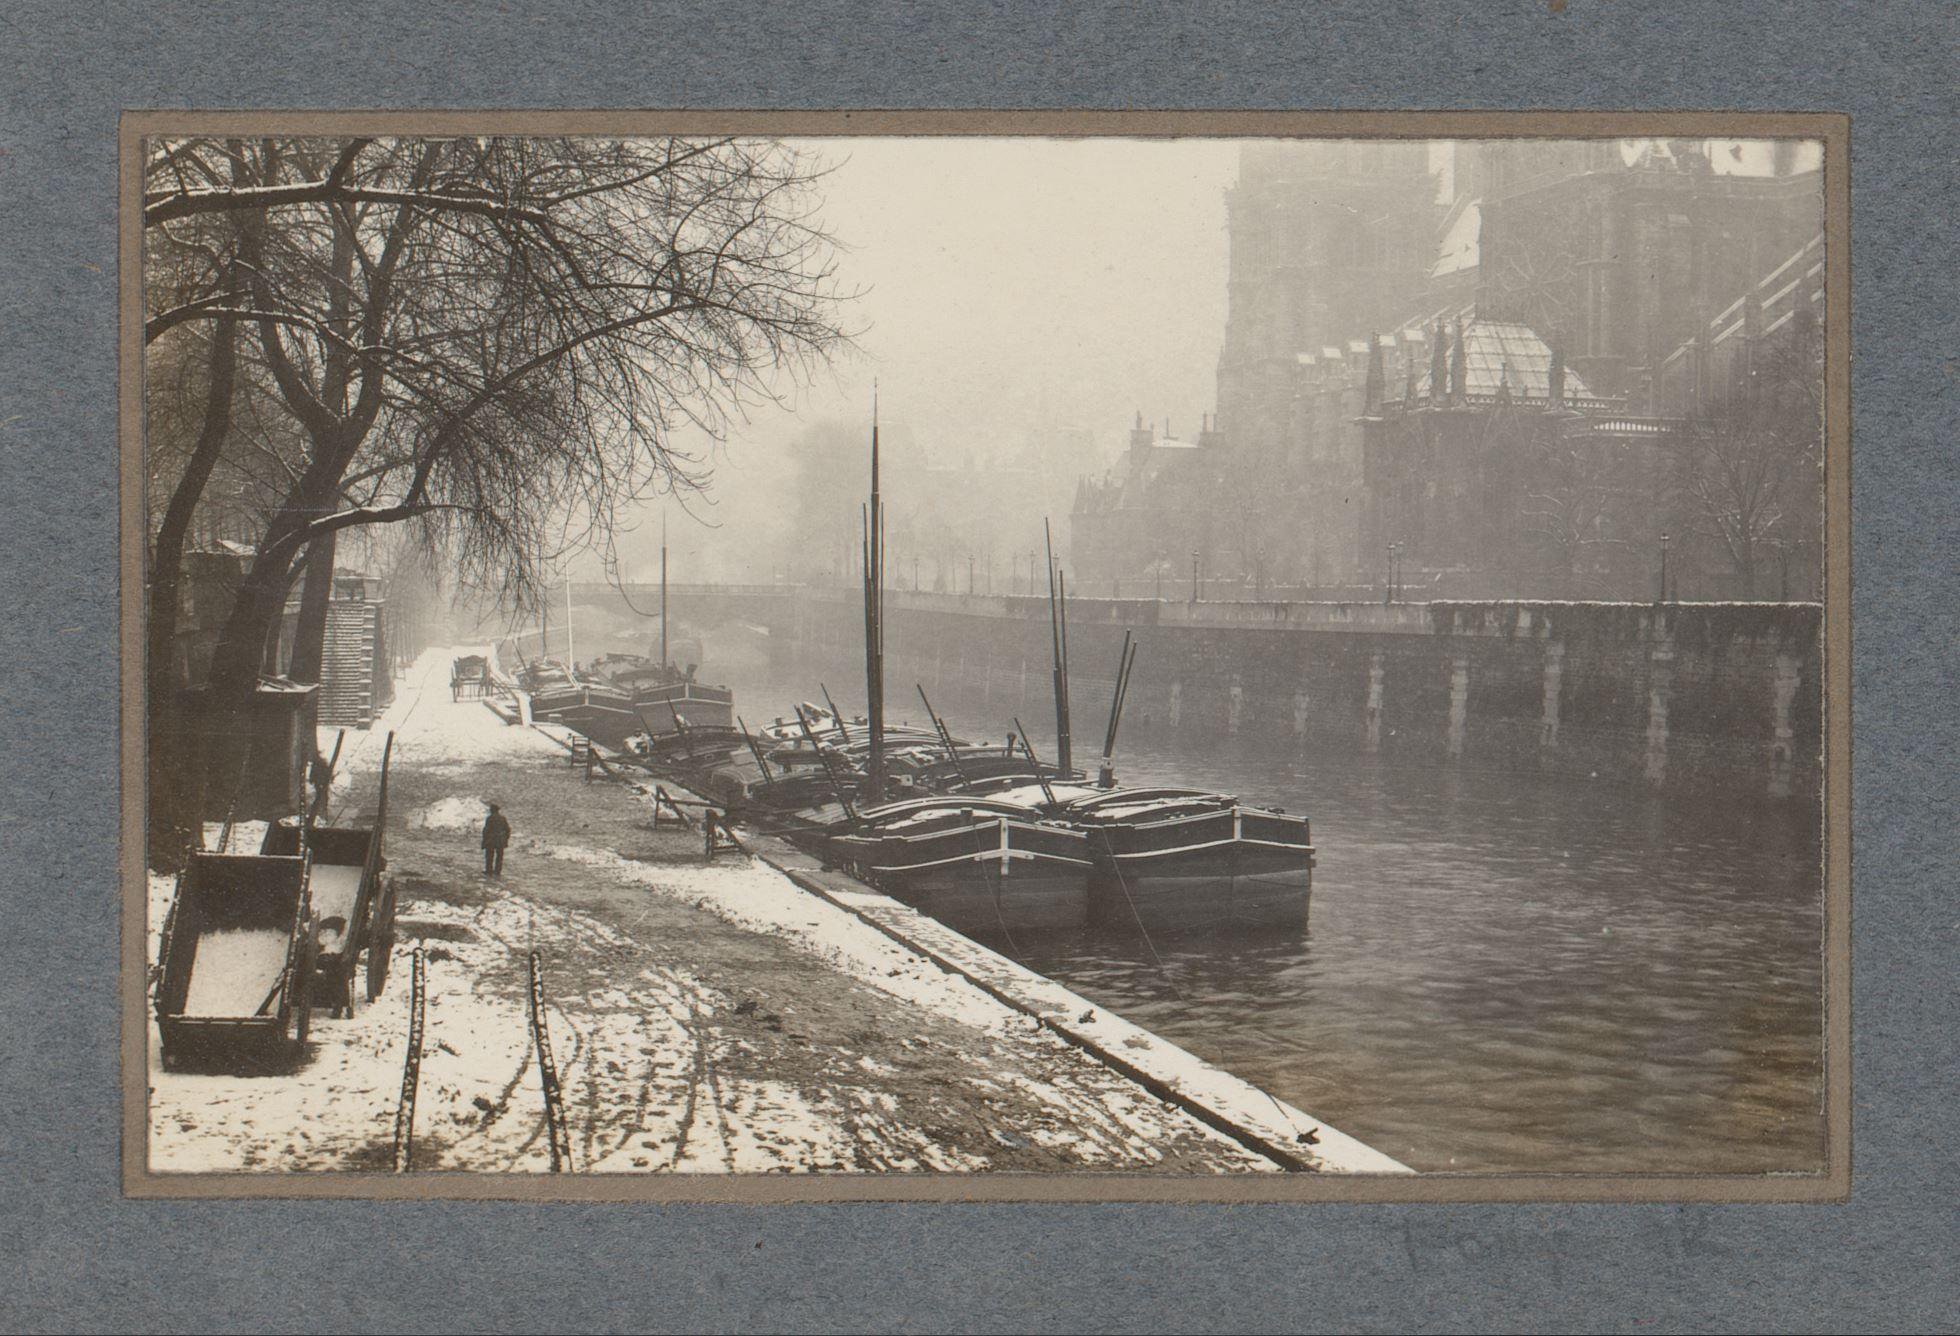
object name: album leaf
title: Gezicht op Parijs in de sneeuw met de Notre-Dame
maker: Anonymous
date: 1914-1927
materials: photographic support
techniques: gelatin silver print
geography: paris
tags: church (exterior), canals, waters (in city), street (+ city(-scape) with figures, staffage)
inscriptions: inscription: ‘Opnamen gemaakt met de Autografische "Kodak"No. 3a./ Afdrukken gemaakt op "Velox" papier.’